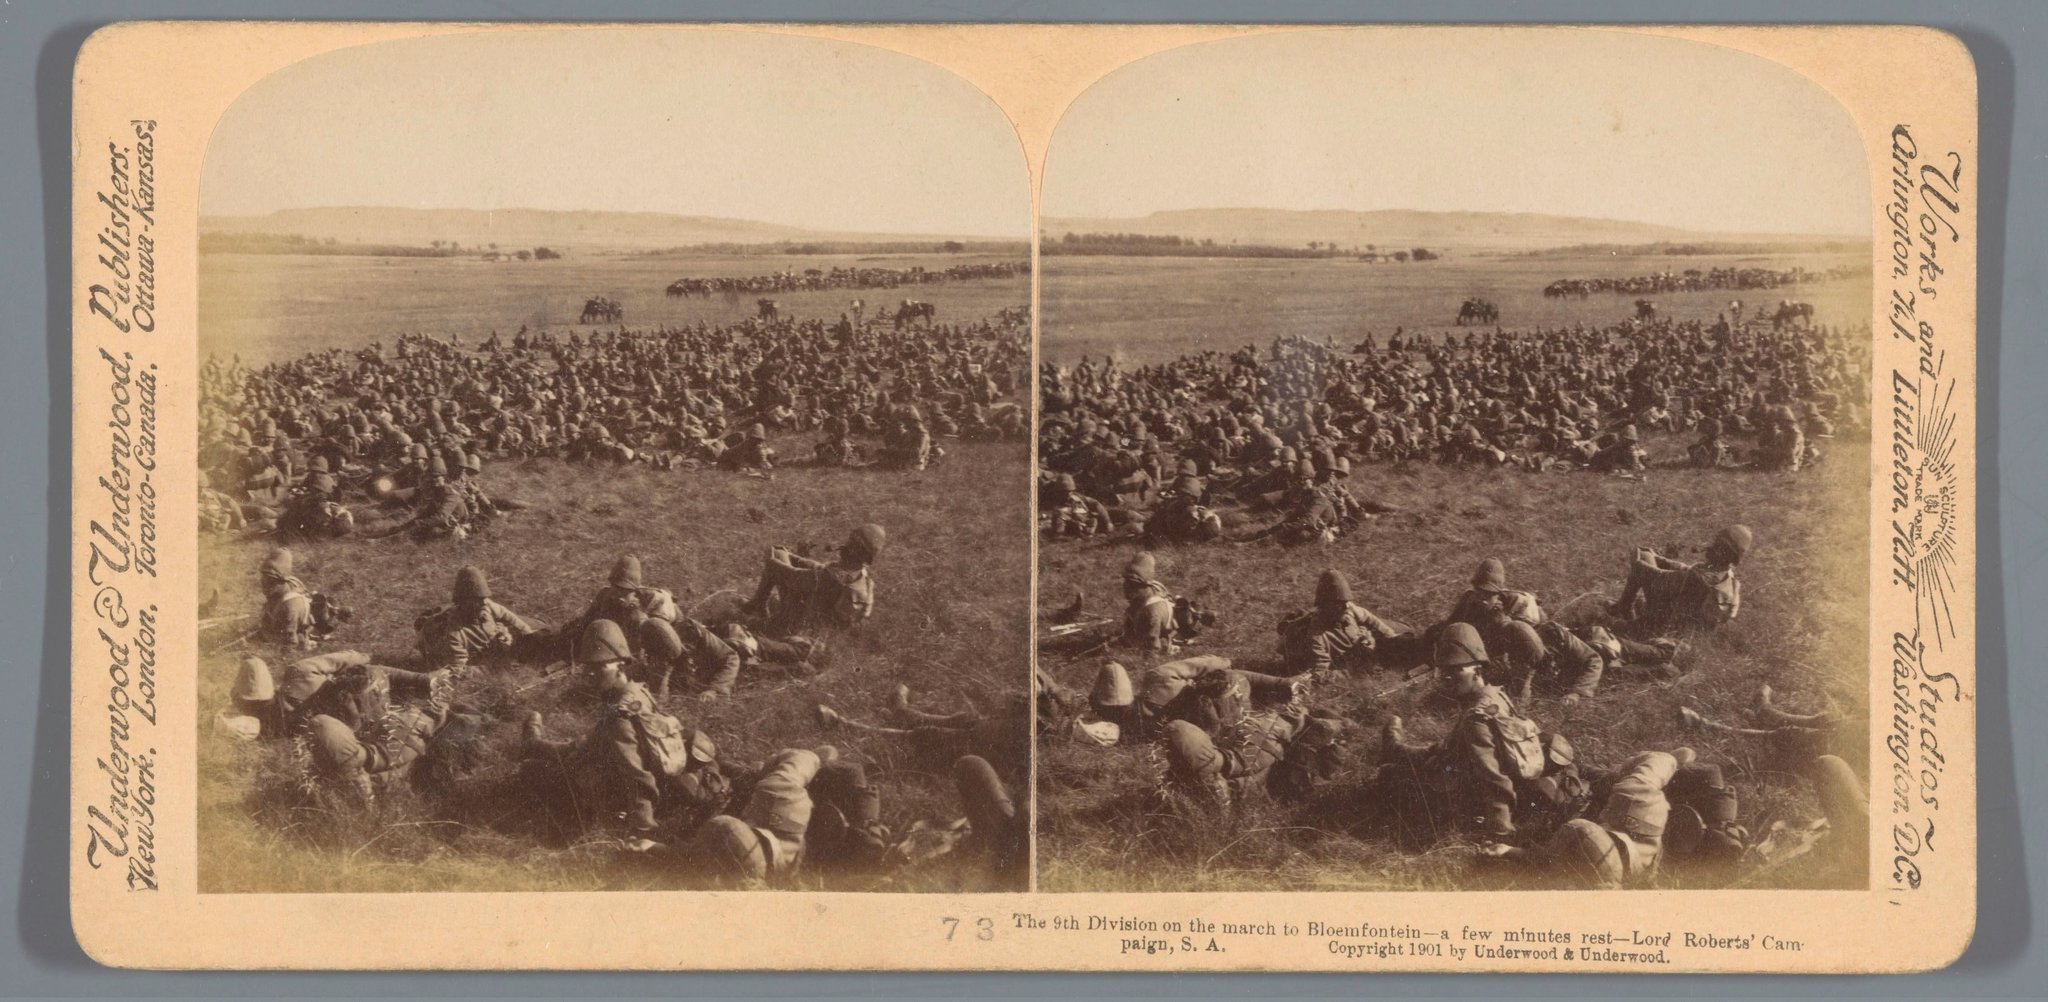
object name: stereograph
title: The 9th Division on the march to Bloemfontein - a few minutes rest - Lord Roberts' Campaign, S.A.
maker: Anonymous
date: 1901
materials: cardboard, paper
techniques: albumen print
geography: south africa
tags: army 'en route', landscapes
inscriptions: copyright notice: ‘Copyright 1901 by Underwood & Underwood.’, inscription, inscription: ‘Works and Studios ~/ Arlington, N.J. Littleton, N.H. Washington, D.C.’, number: ‘73’